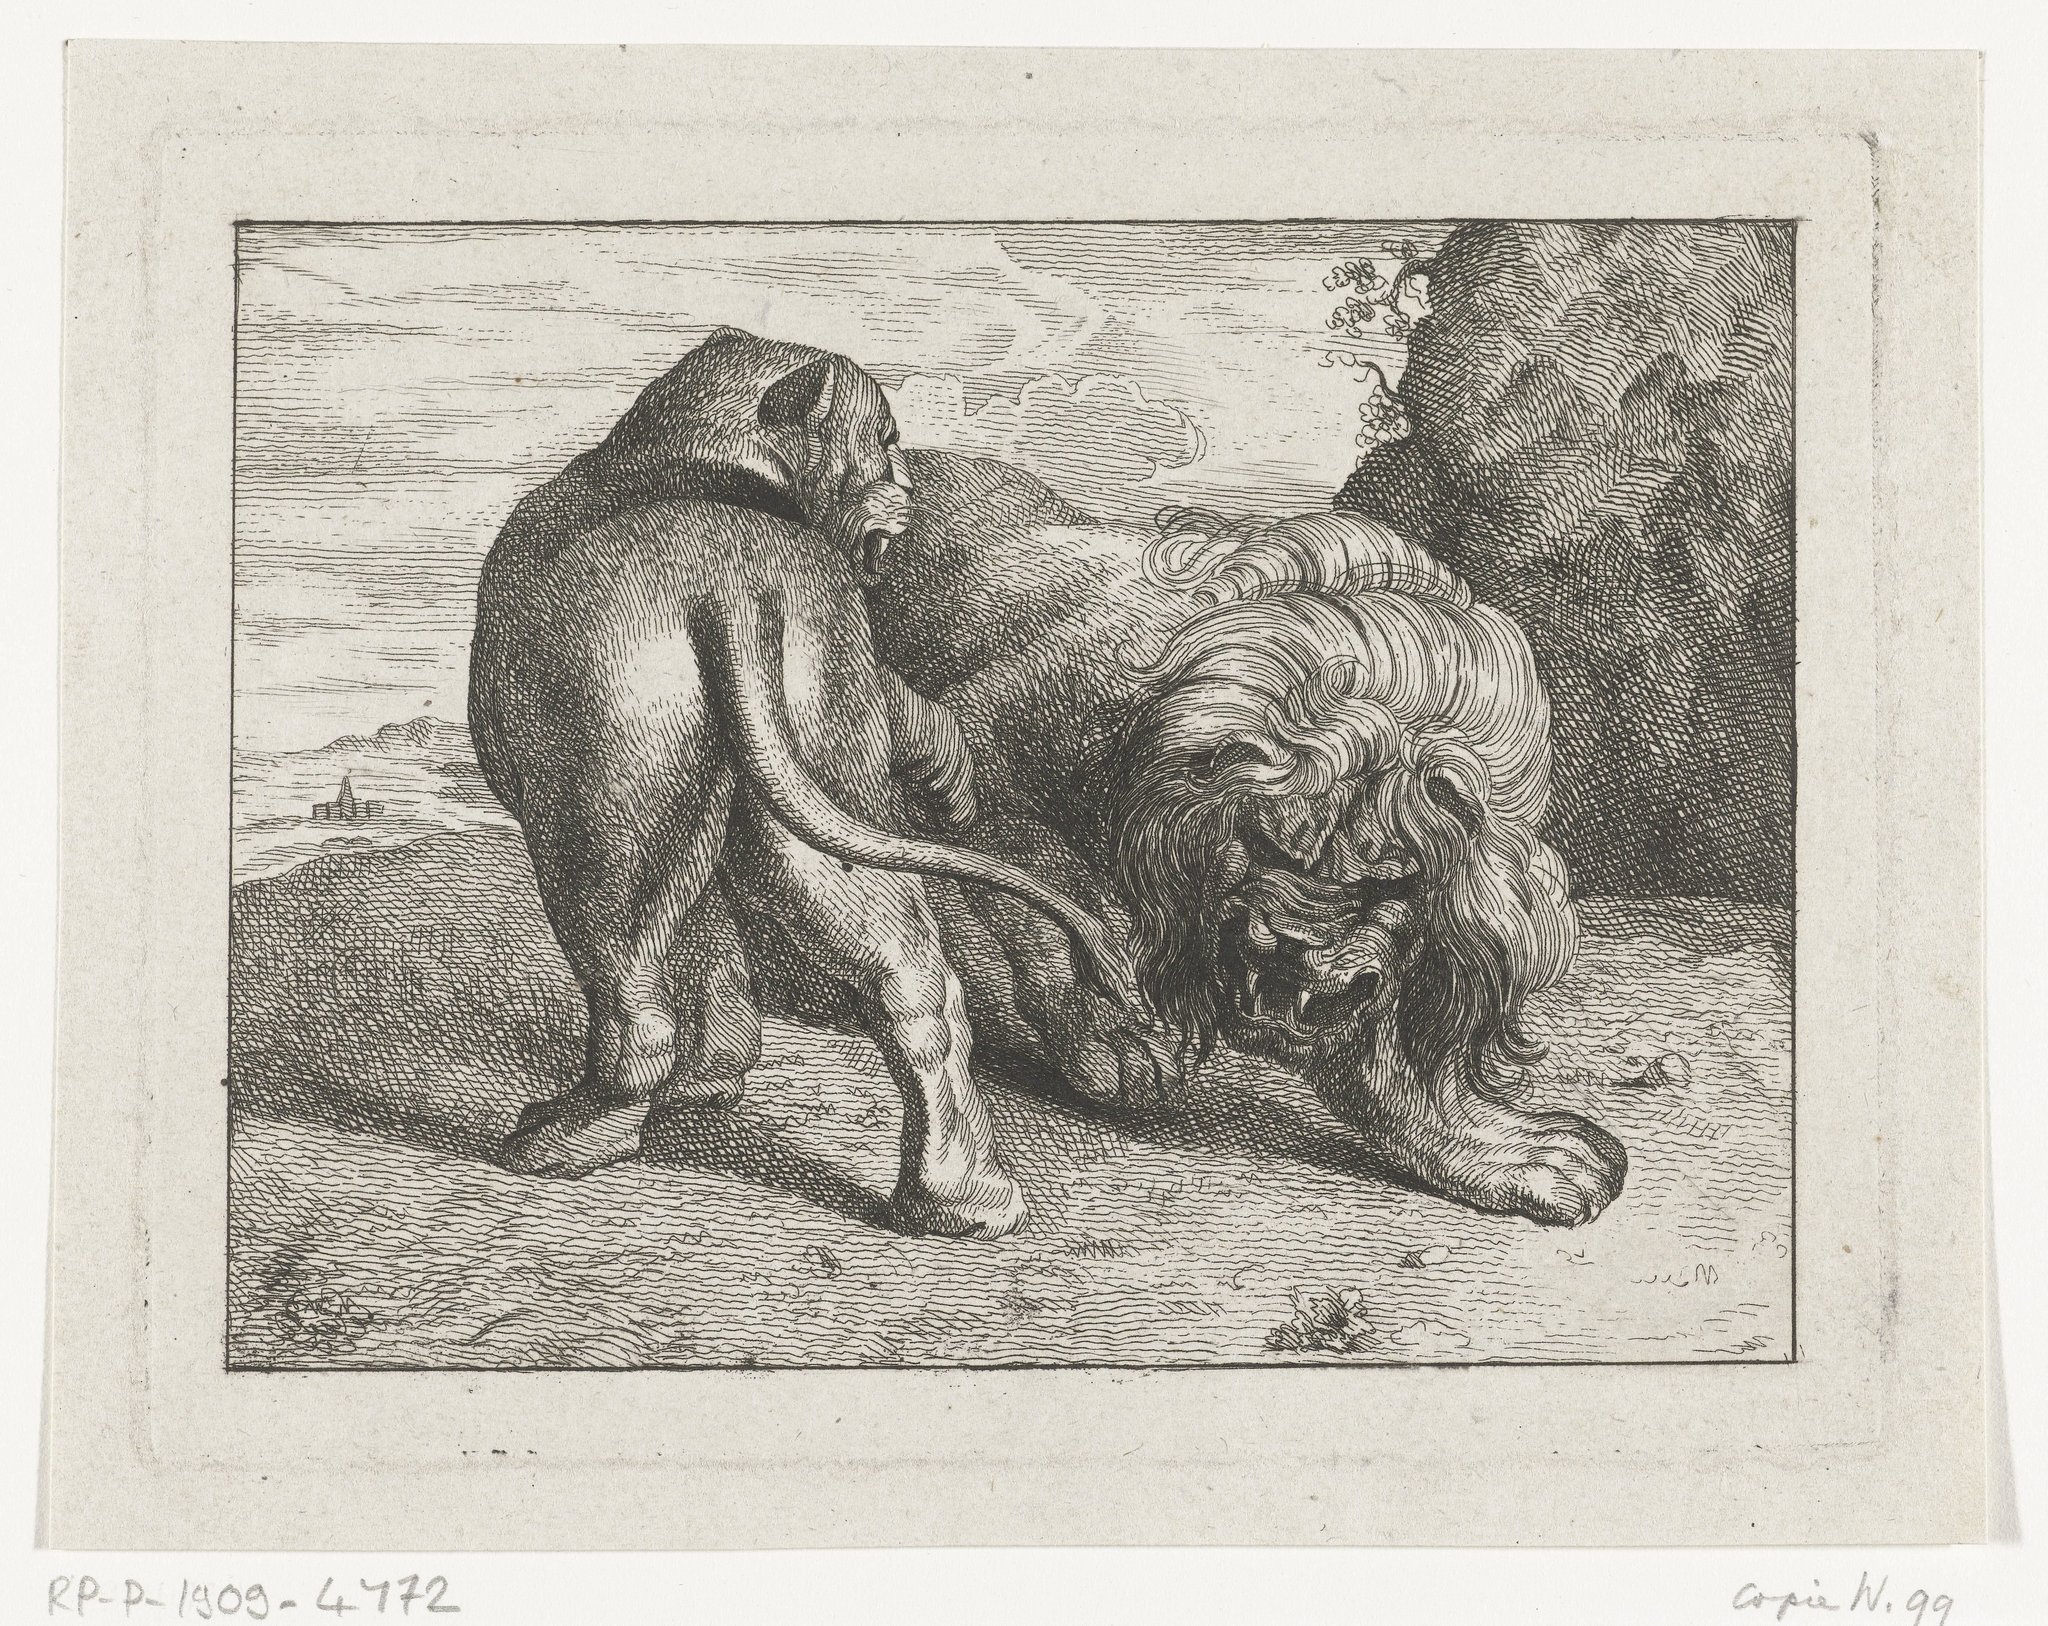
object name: print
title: Portret van Clementine van Oostenrijk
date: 1821-1841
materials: paper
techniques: engraving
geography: italy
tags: historical persons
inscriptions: collector's mark: Lugt 2228